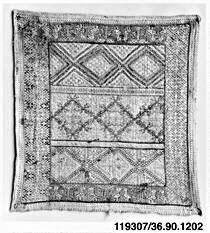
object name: panel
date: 1801-1900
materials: linen, silk